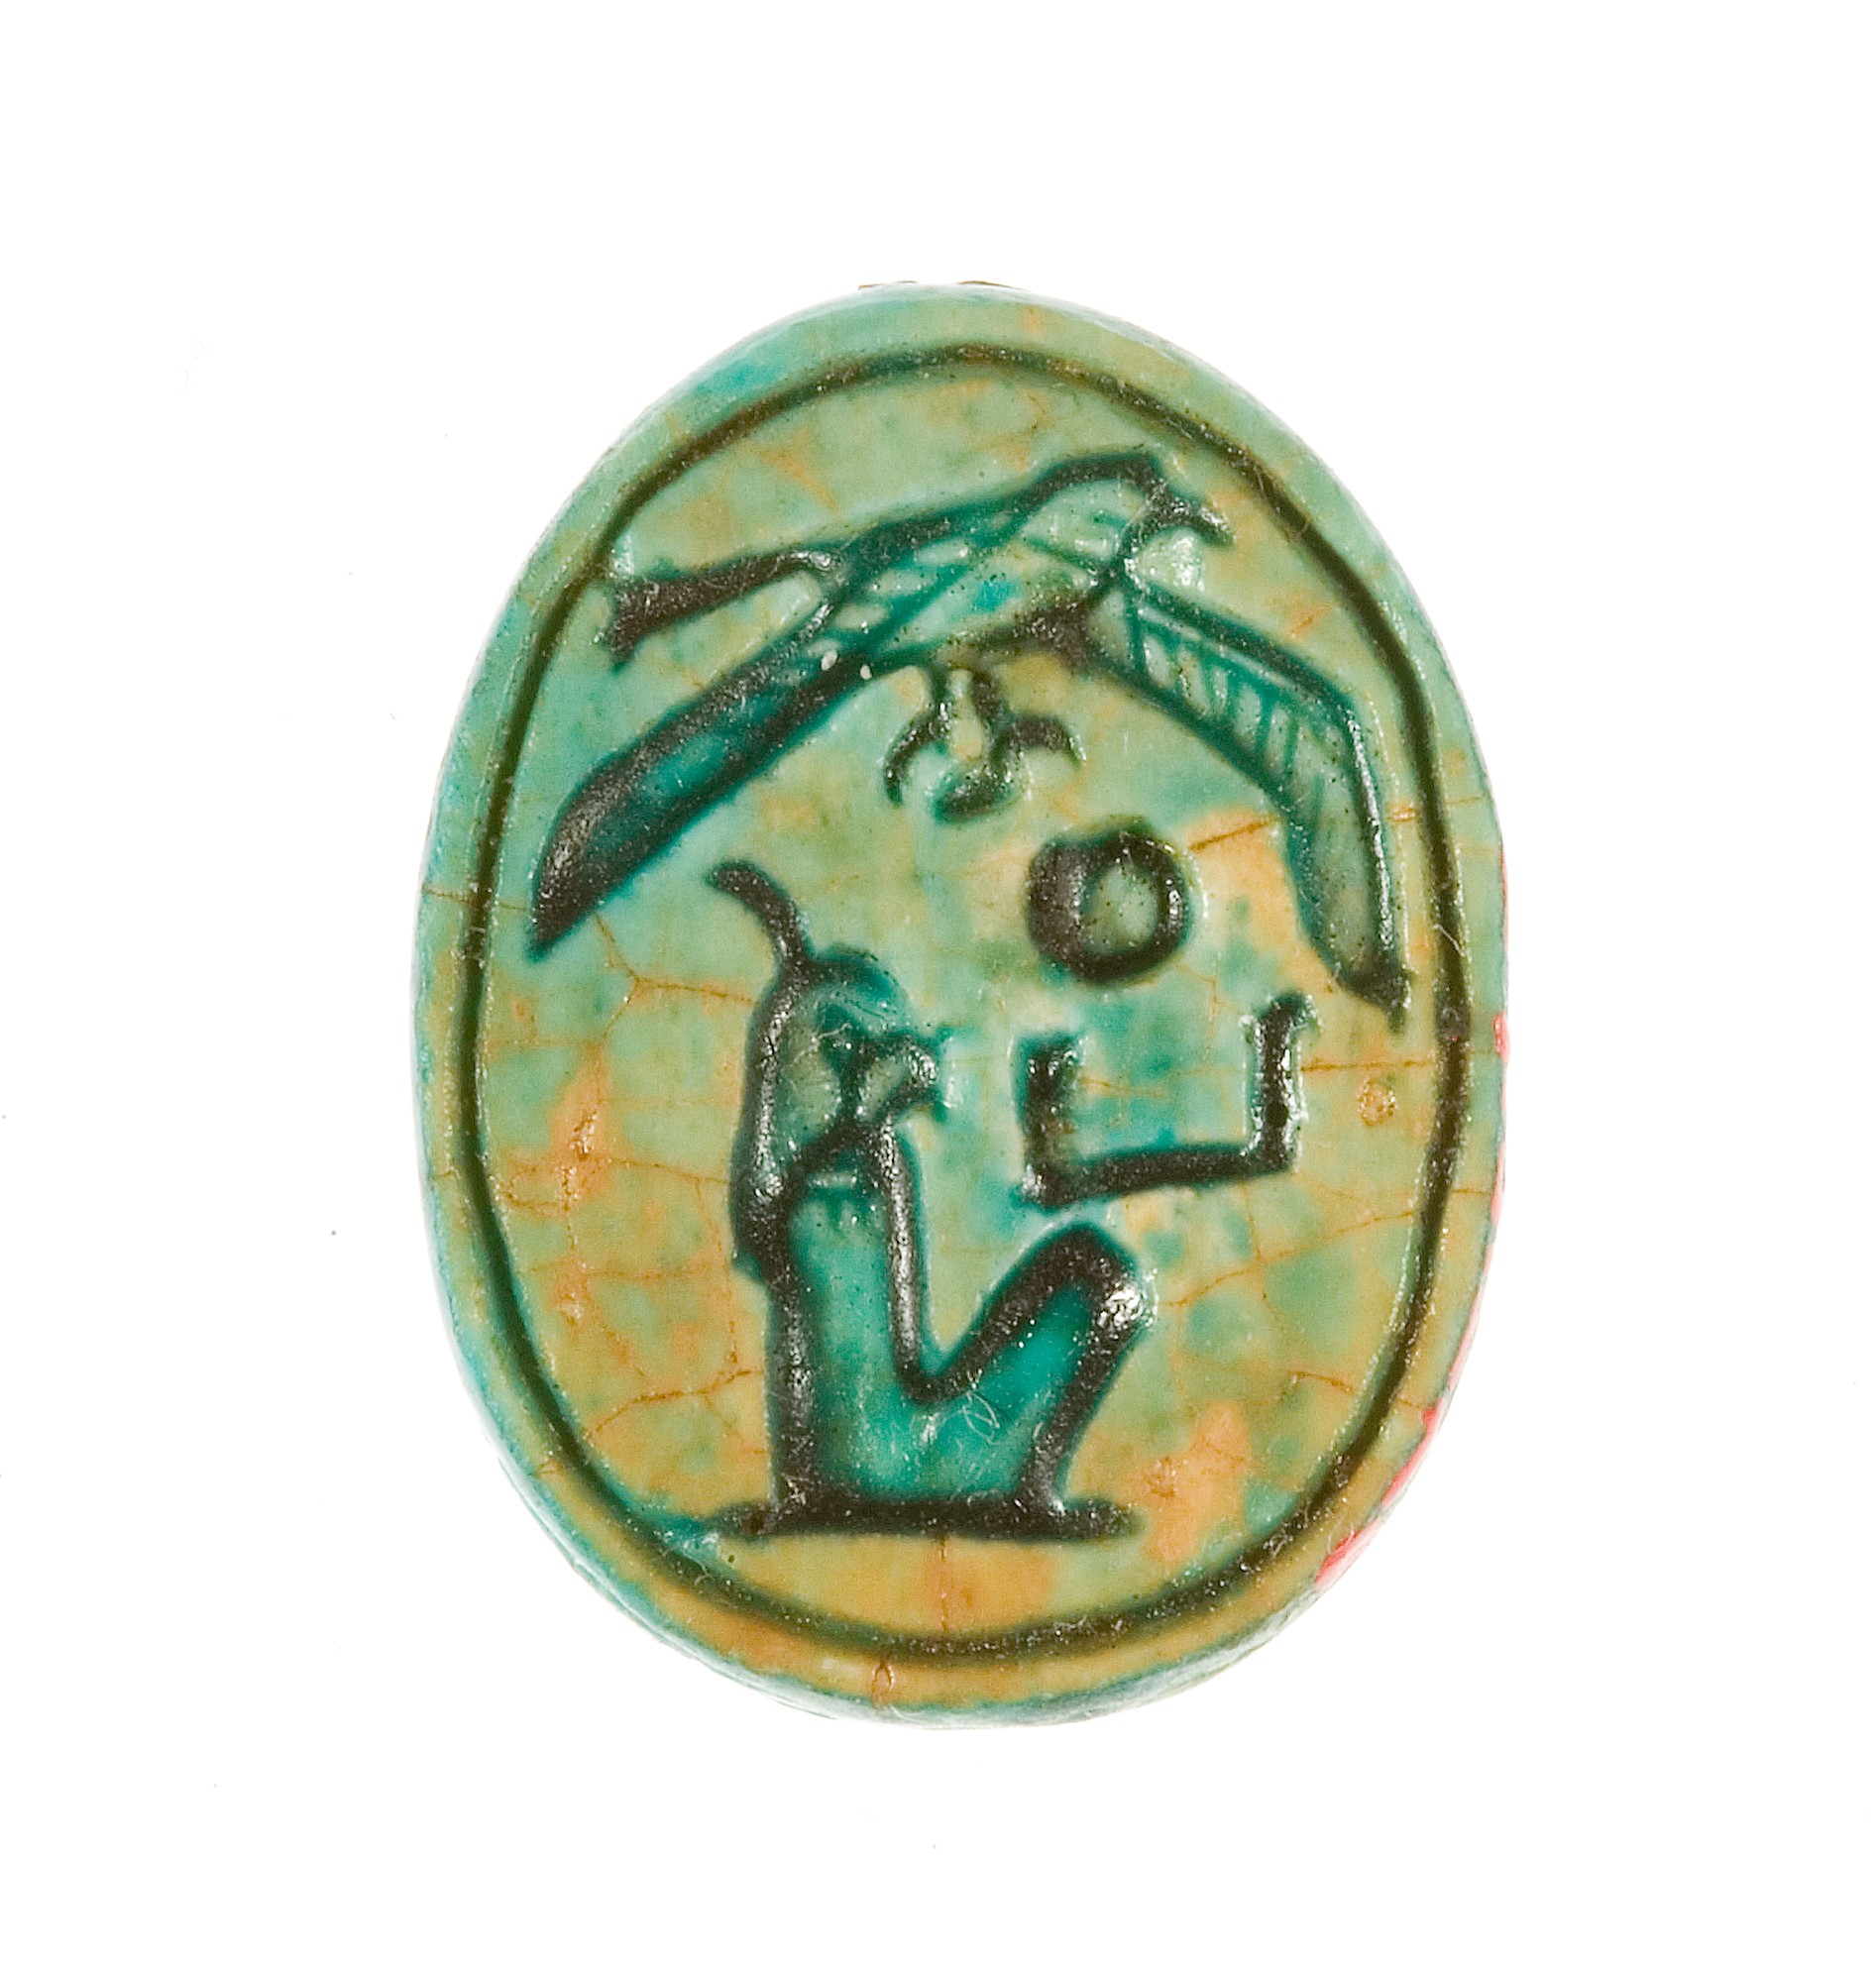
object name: scarab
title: Scarab Inscribed with the Name Maatkare (Hatshepsut) with a Falcon Above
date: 1479-1458 BCE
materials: stone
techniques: glazing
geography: egypt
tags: falcons,hieroglyphs,scarabs